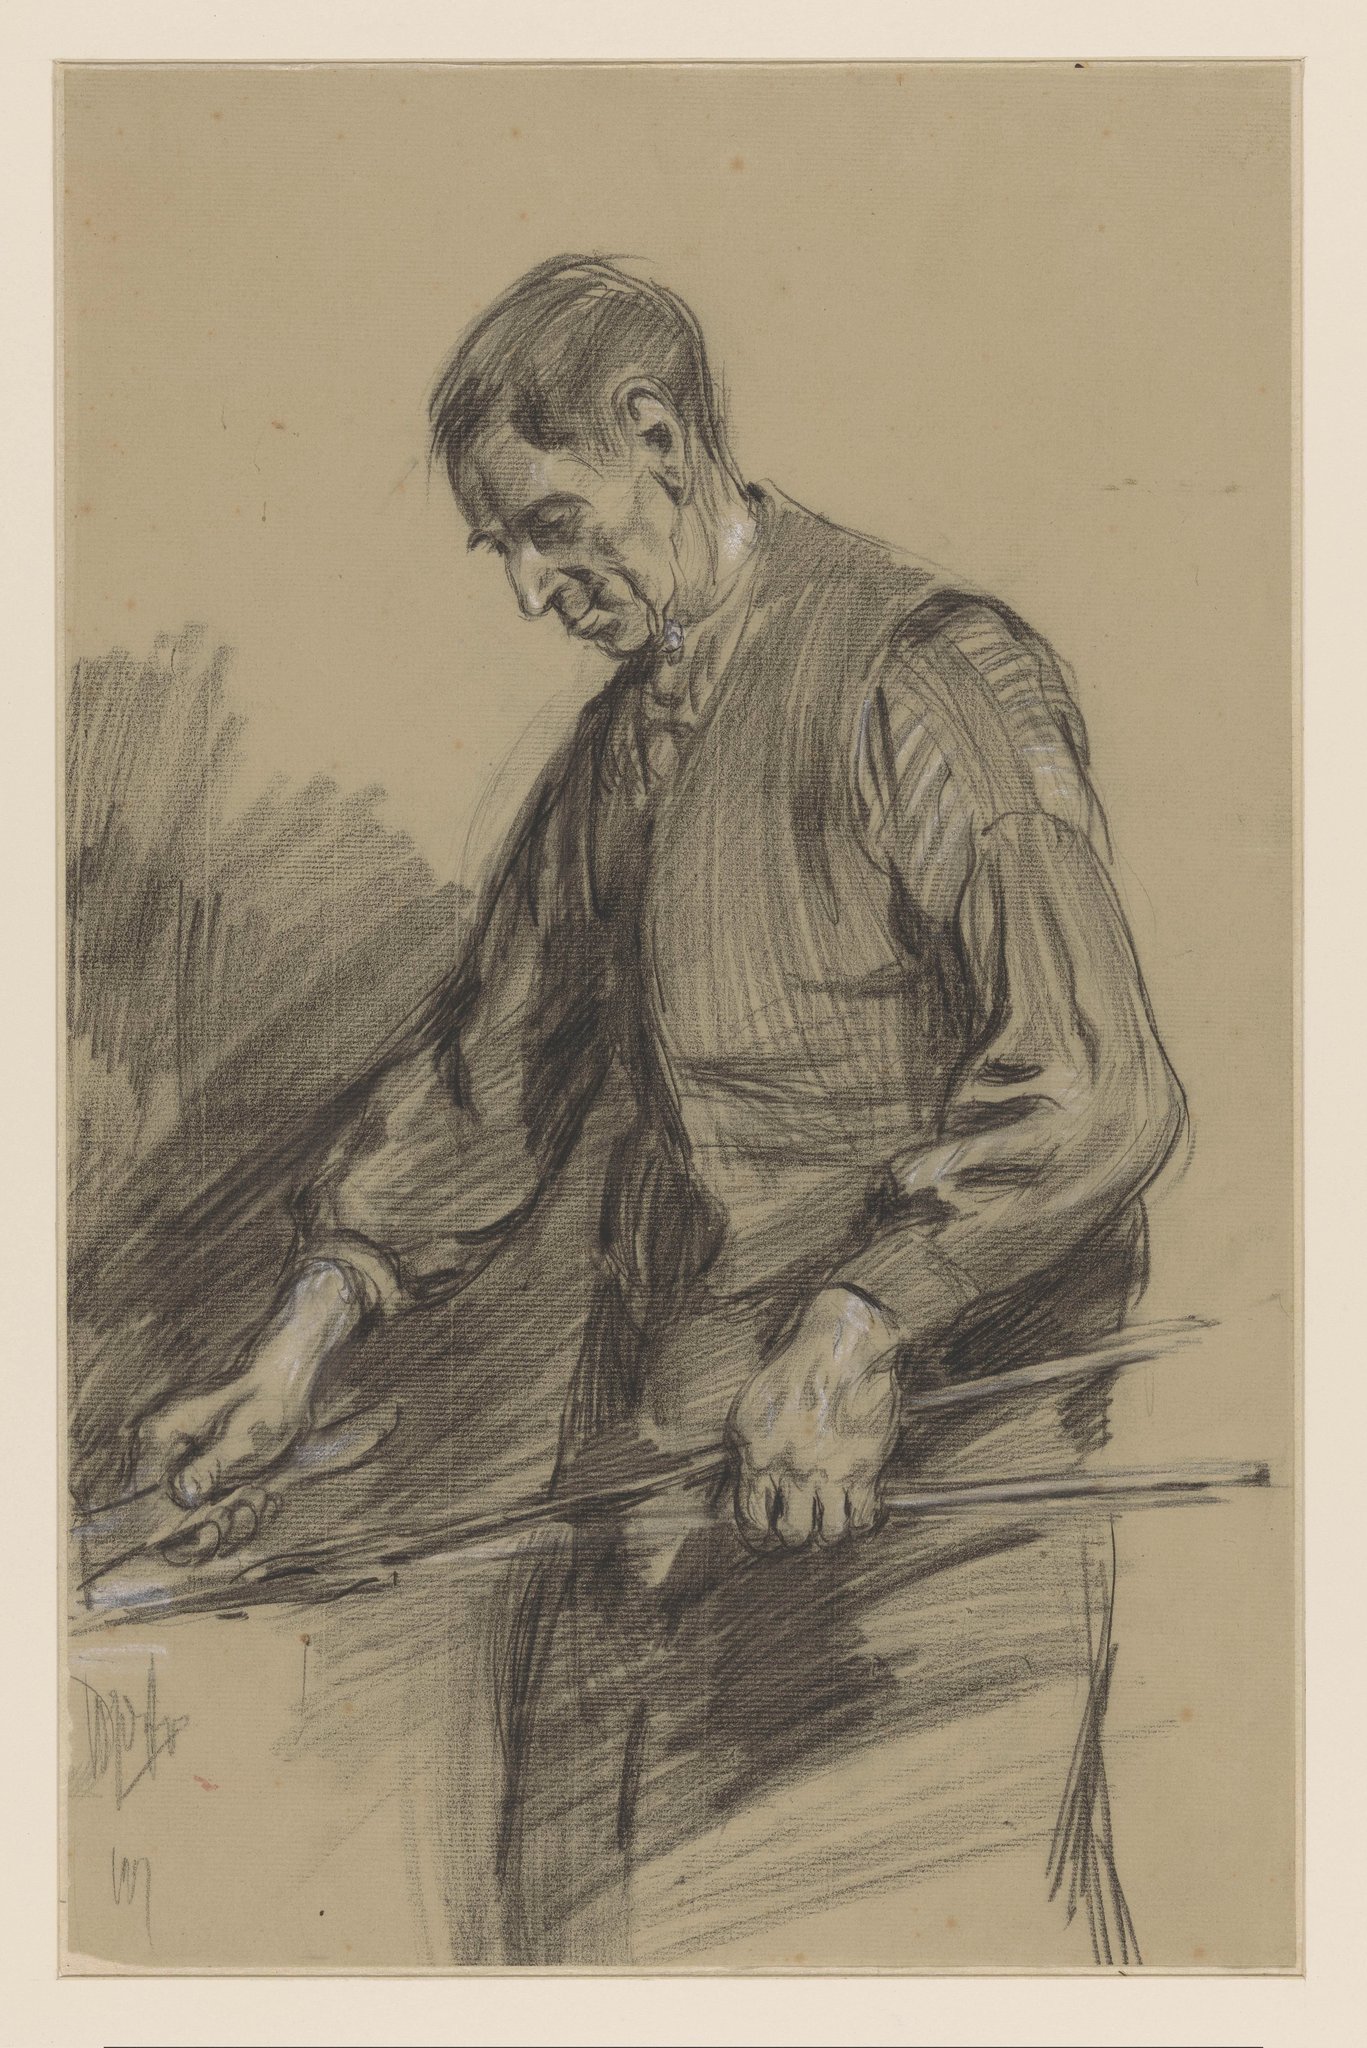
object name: design drawing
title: Ontwerp voor de kastwand van de hofapotheek te Ansbach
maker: Anonymous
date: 1734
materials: graphite, ink, paper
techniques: pen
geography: ansbach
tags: pharmacy, pharmaceutics, cupboard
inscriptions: size, date: ‘17 / 34’, watermark, inscription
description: Ontwerp voor de kastwand van de hofapotheek te Ansbach, met onder het vooraanzicht een doorsnede van boven af.